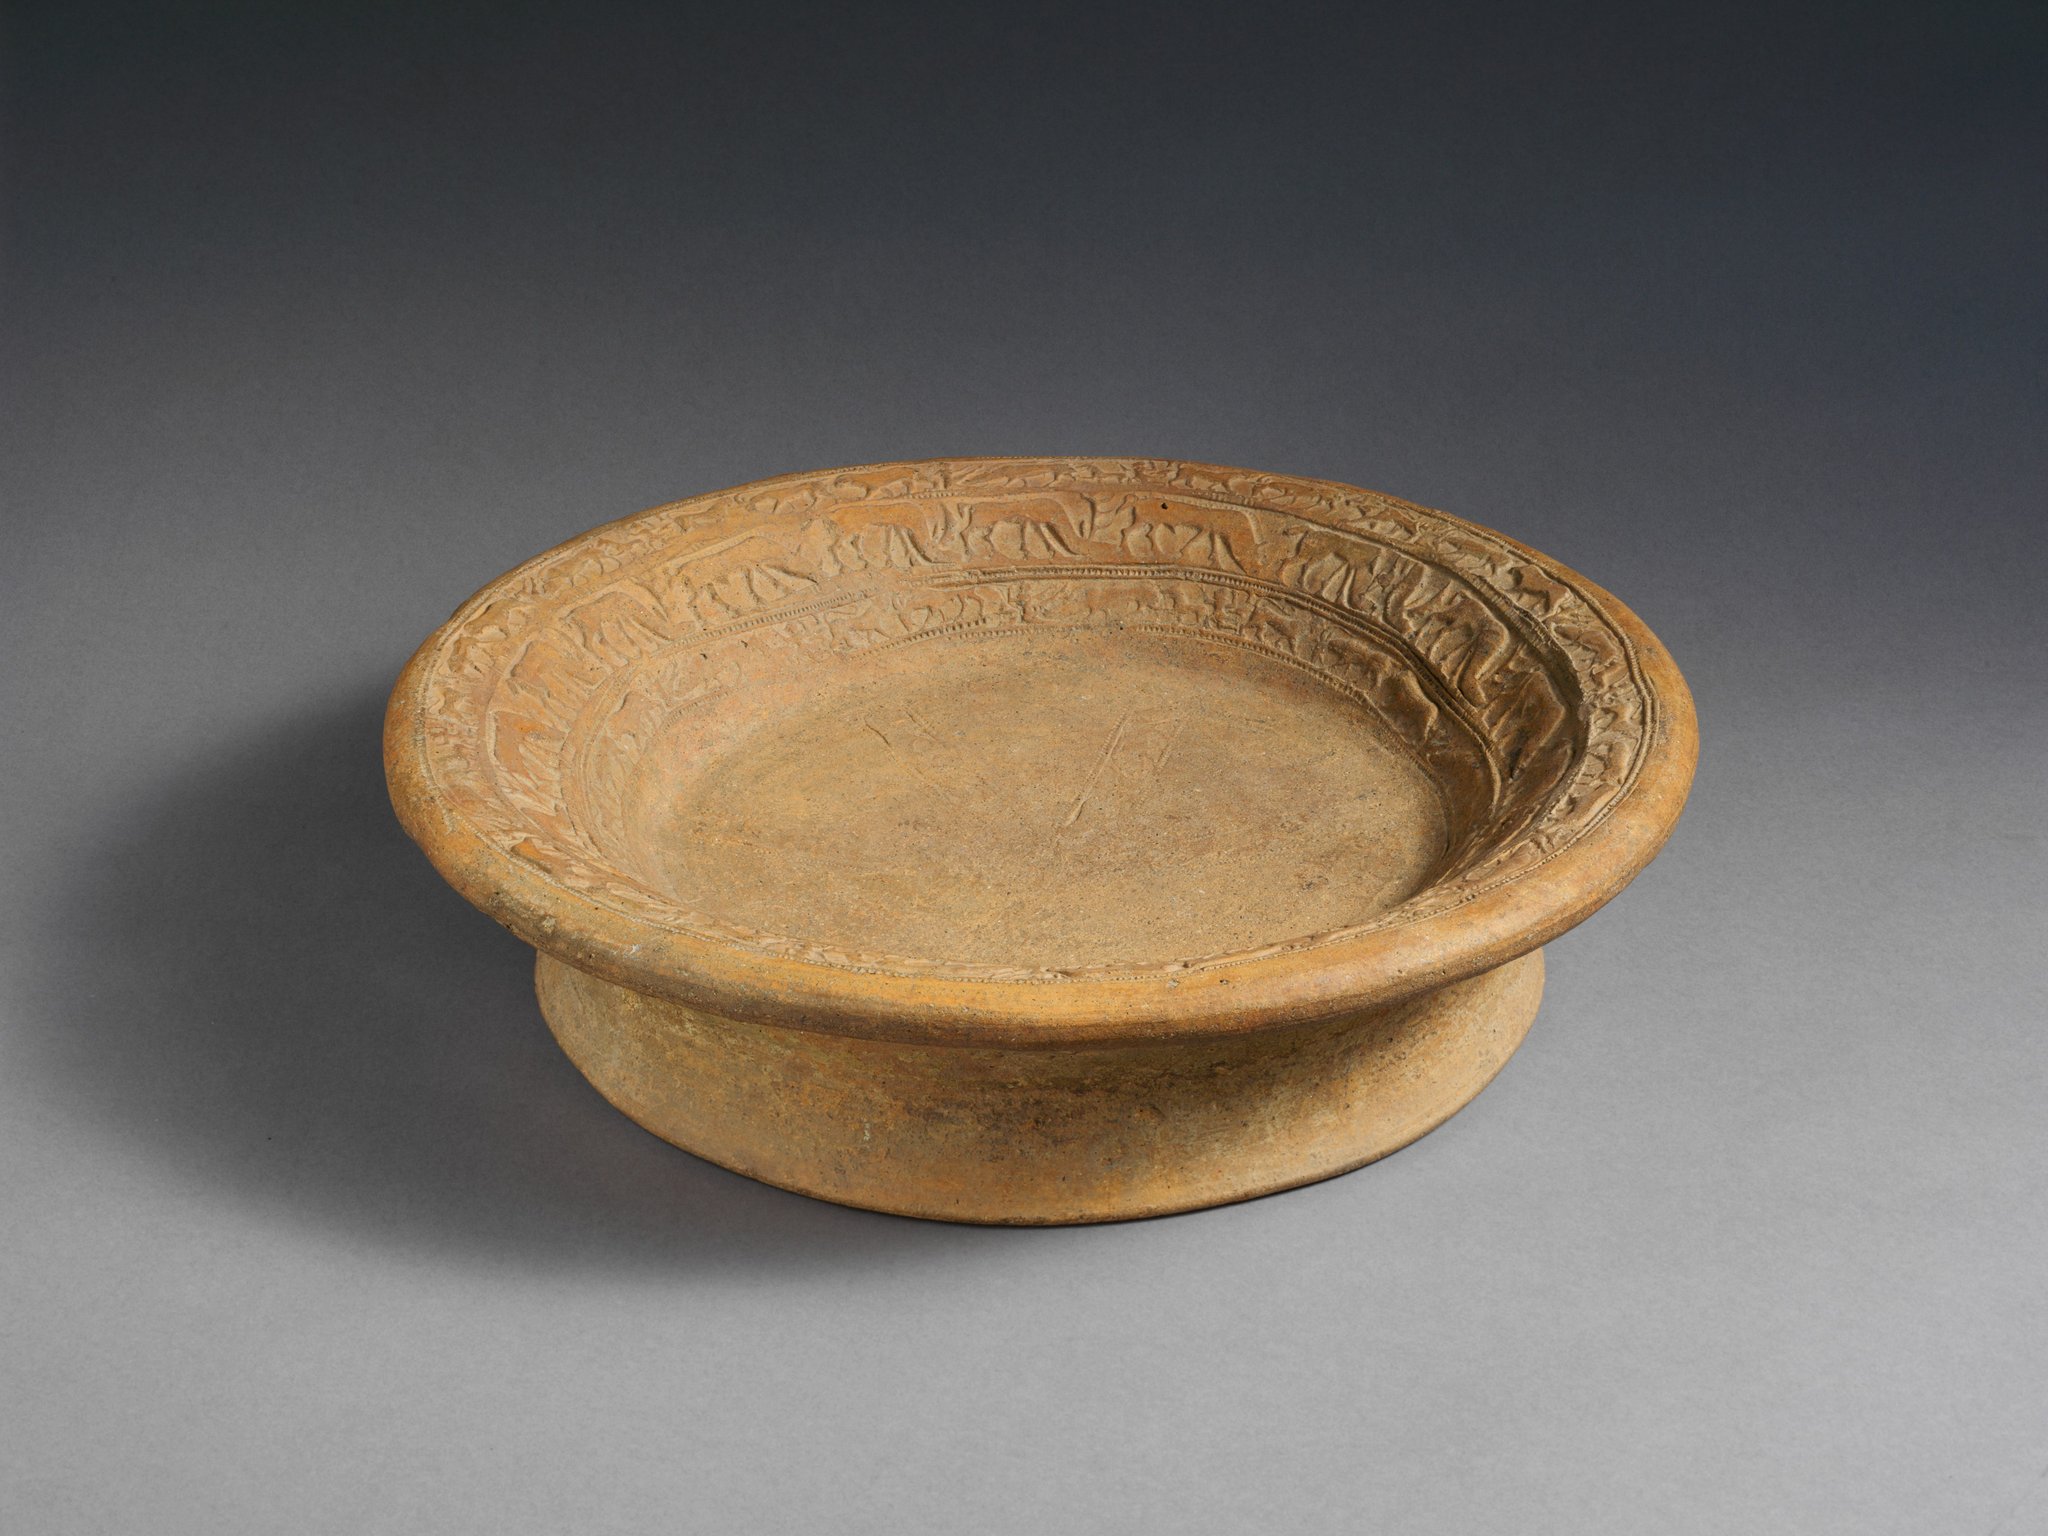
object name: brazier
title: Terracotta brazier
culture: etruscan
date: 600-530 BCE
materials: terracotta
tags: animals